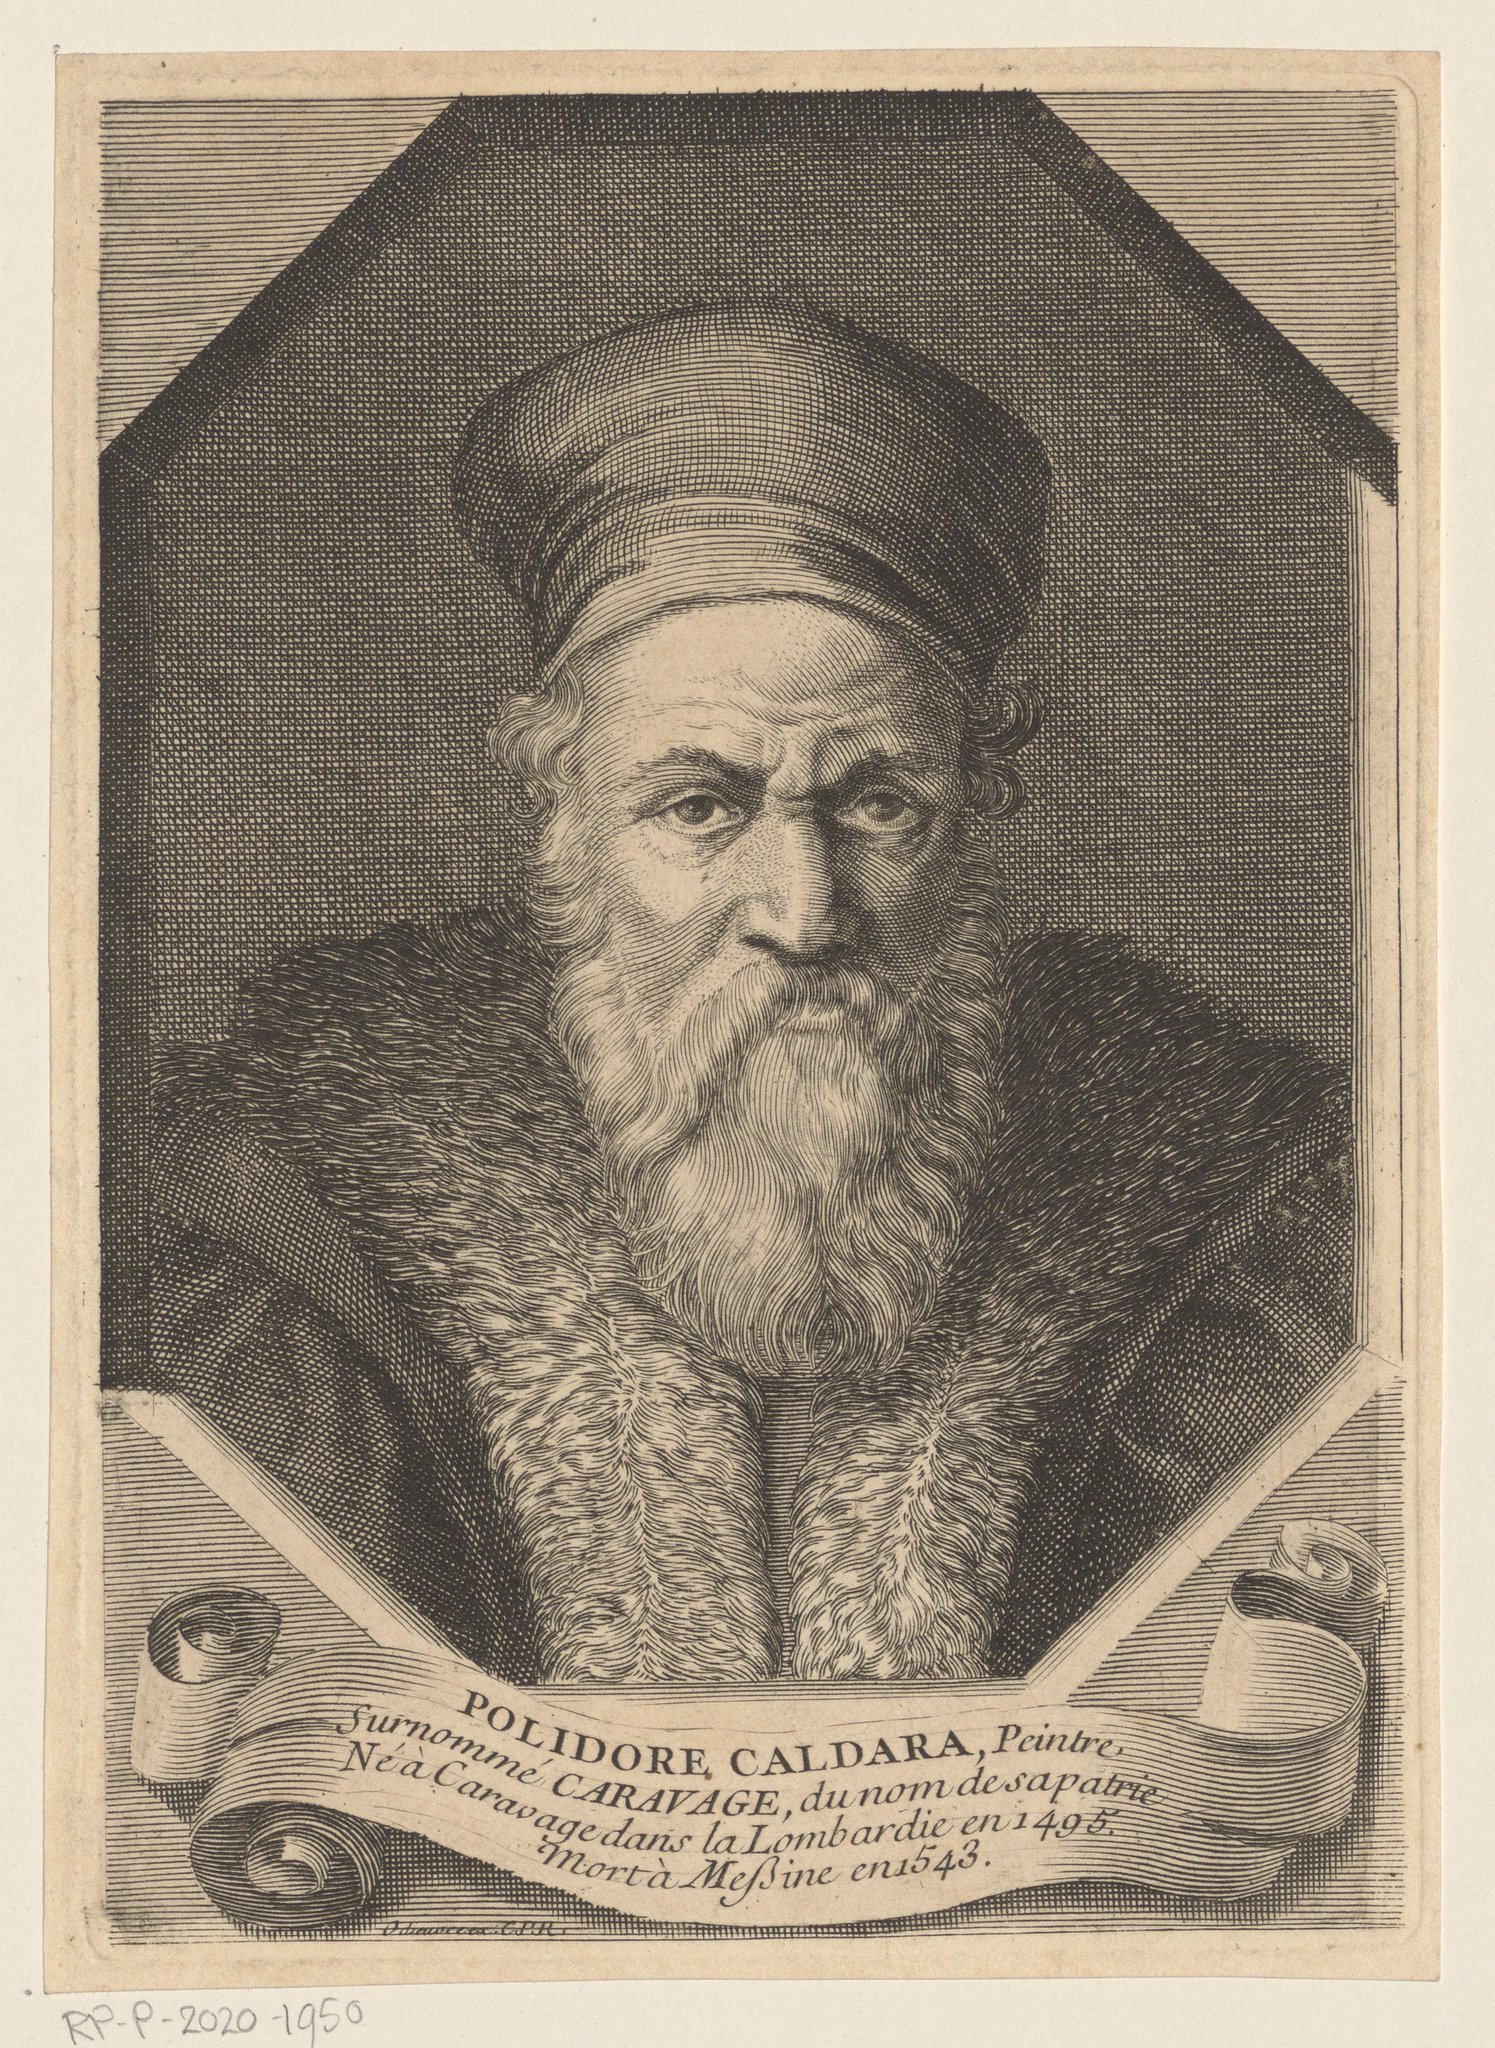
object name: print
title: Portret van Polidoro da Caravaggio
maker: michel odieuvre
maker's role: painter, print maker, publisher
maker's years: 1687-1756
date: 1697-1756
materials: paper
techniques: engraving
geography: paris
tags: draughtsman, polidoro da caravaggio, historical persons